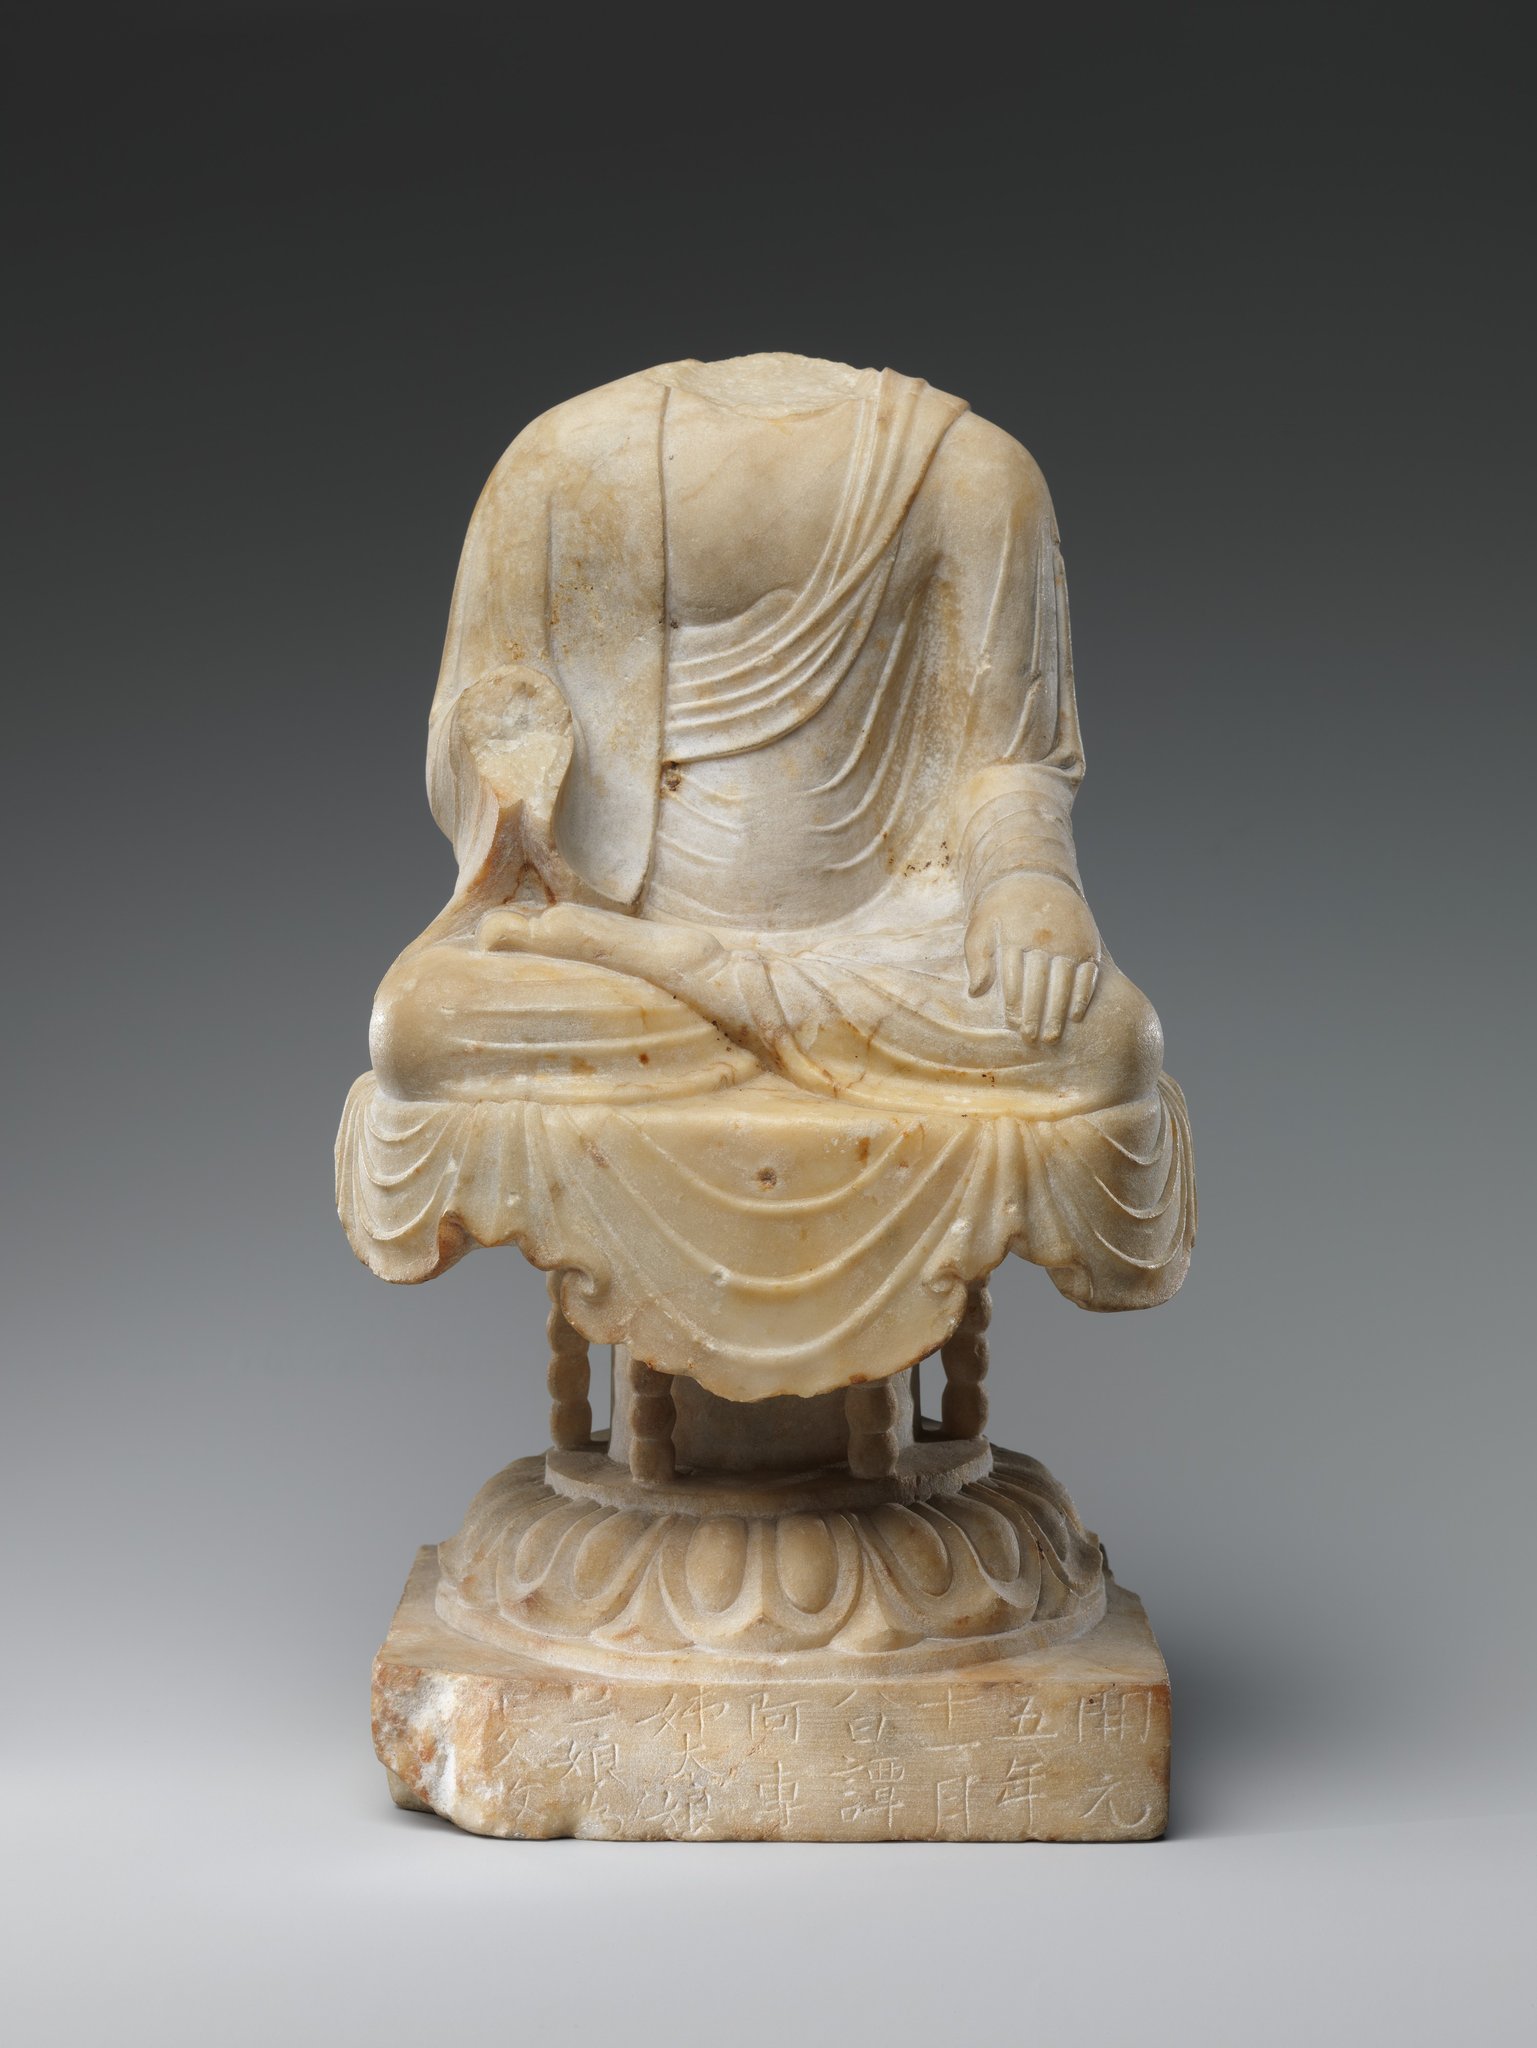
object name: headless figure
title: Buddha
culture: chinese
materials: marble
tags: buddha